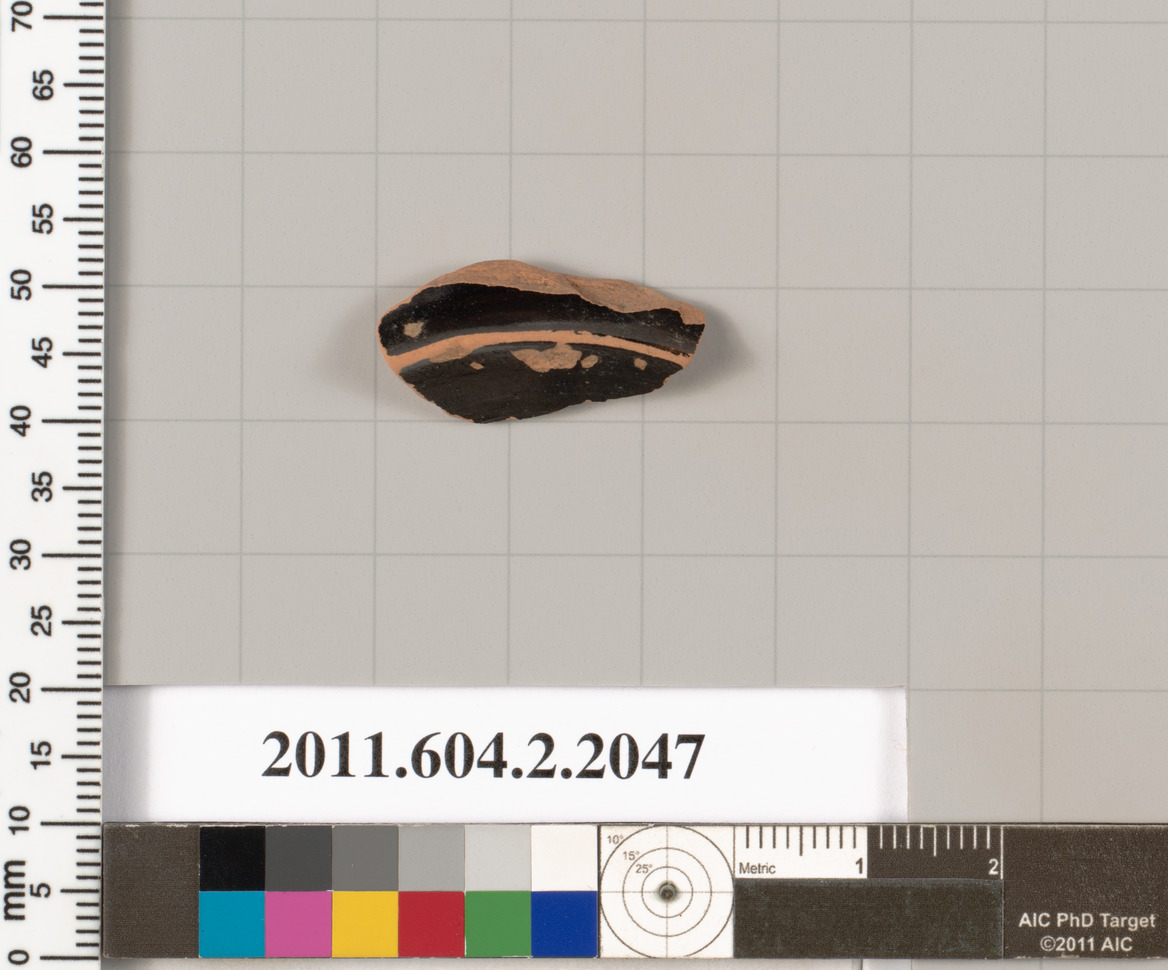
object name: kalathos fragment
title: Terracotta fragment of a kalathos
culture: greek, attic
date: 520-500 BCE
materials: terracotta